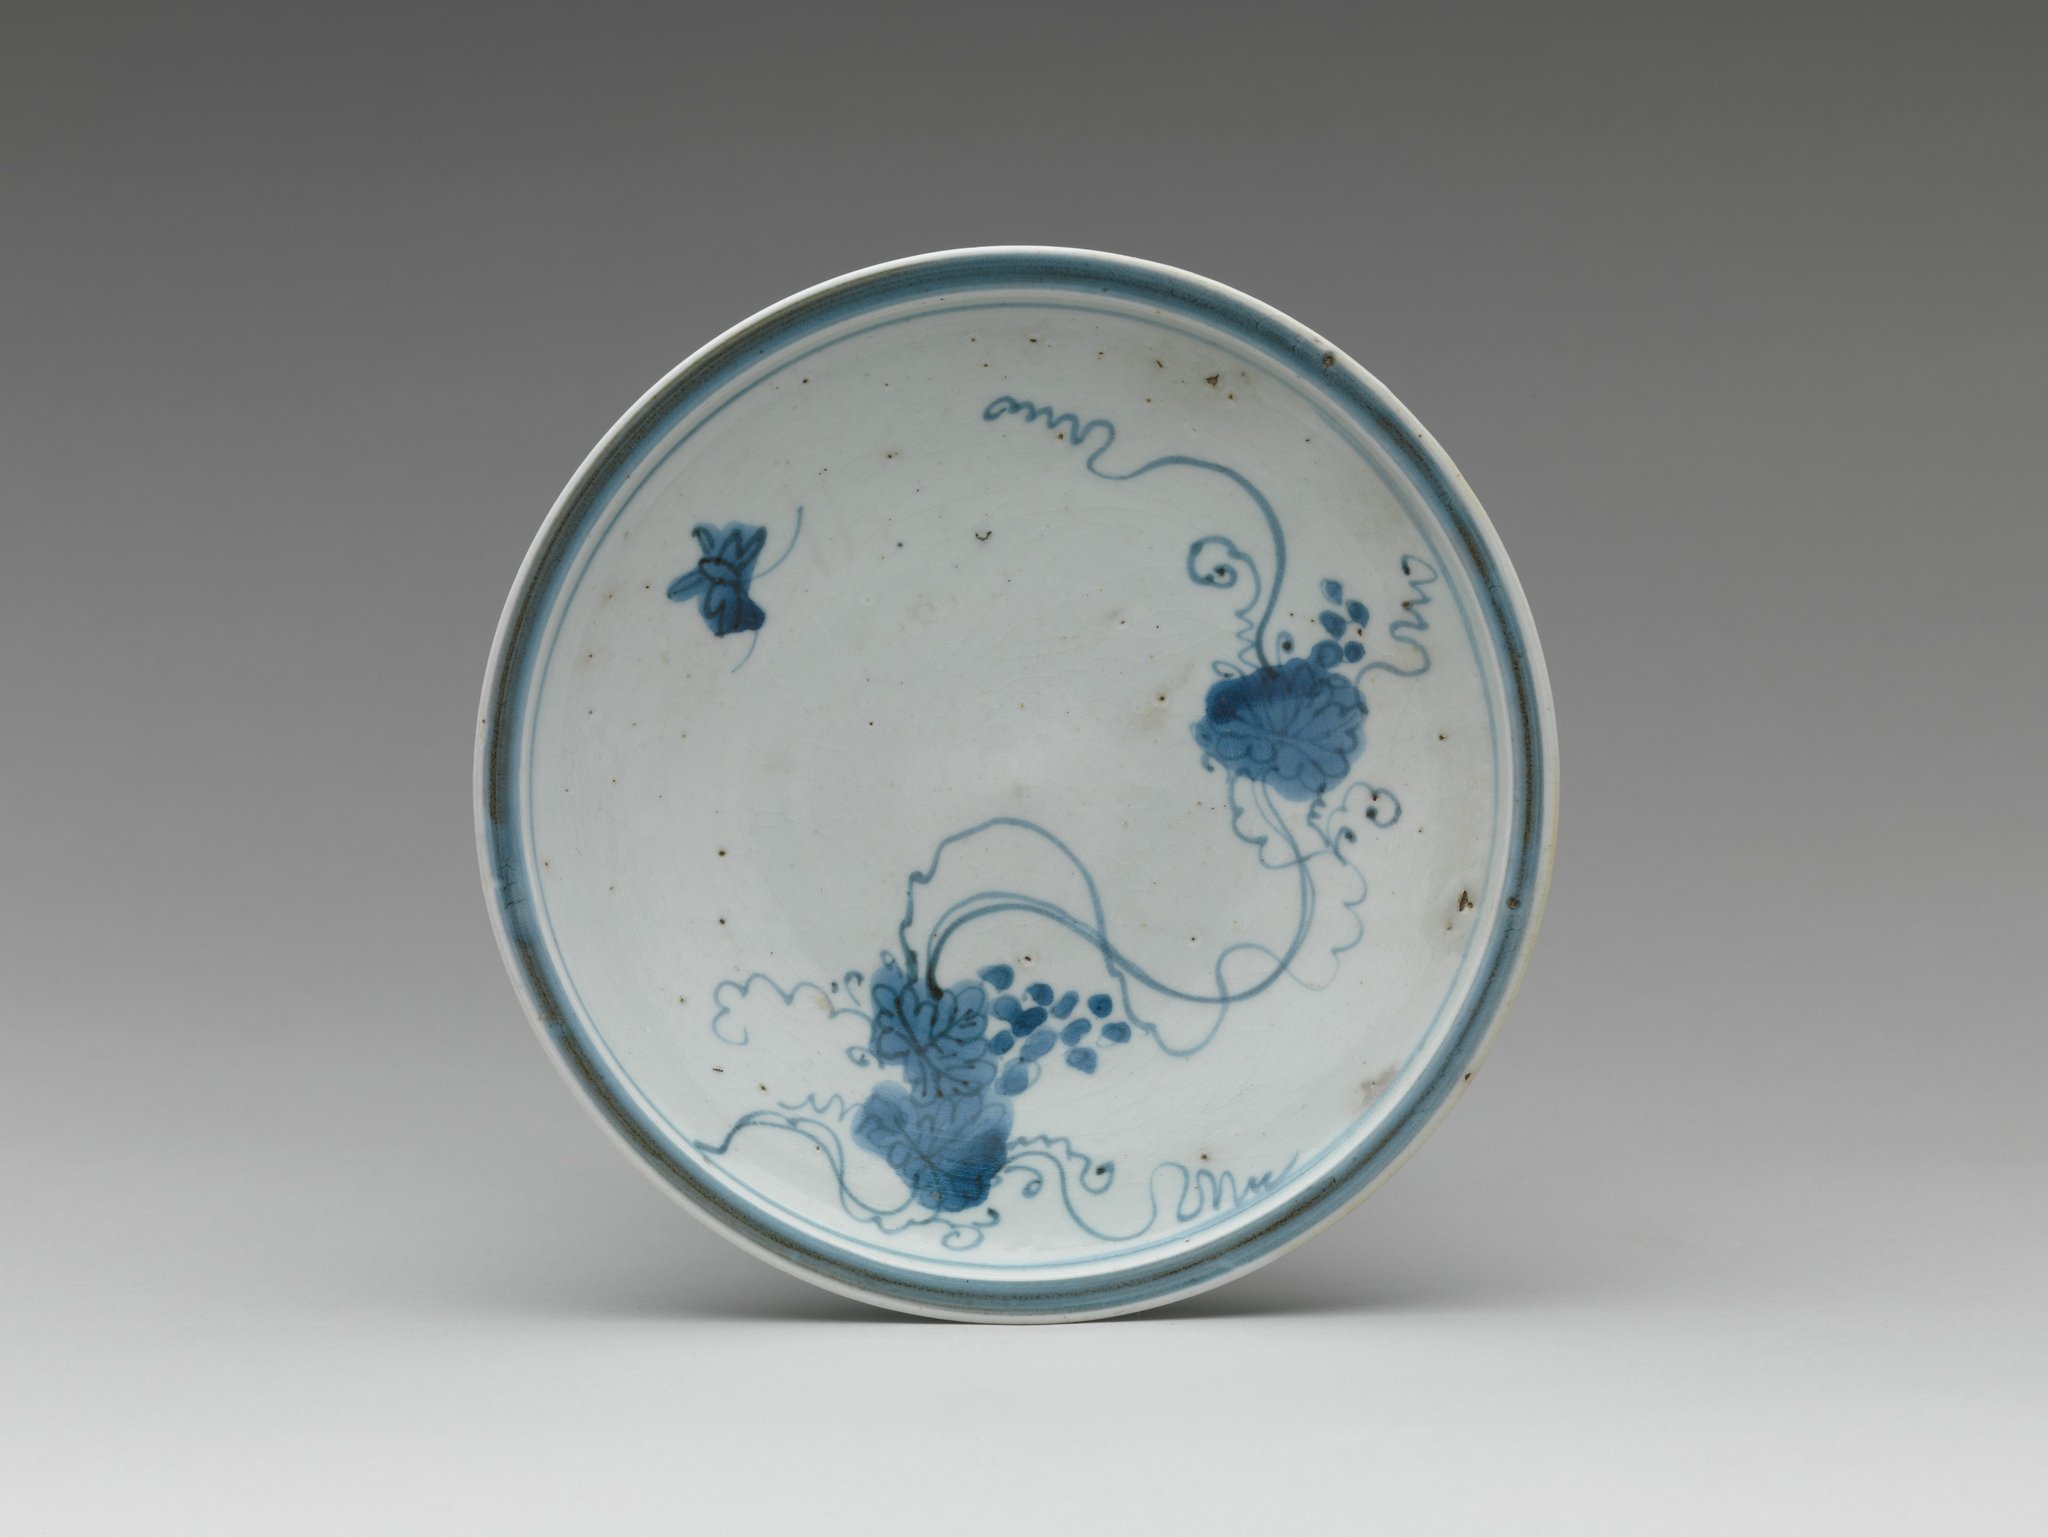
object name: dish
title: Dish with Grapevine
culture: japanese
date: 1601-1650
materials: cobalt, glaze, porcelain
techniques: painting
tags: butterflies,vines